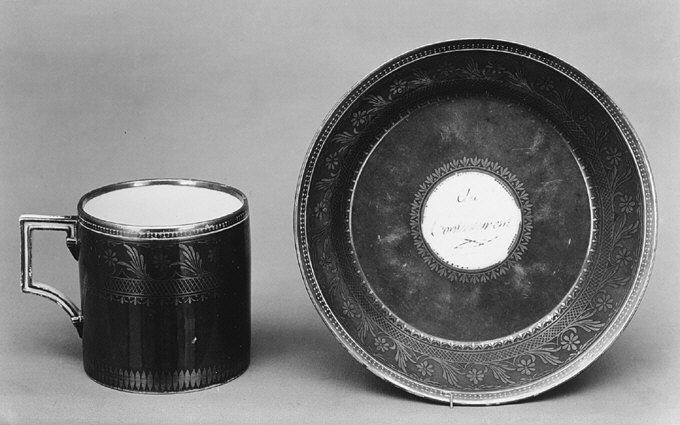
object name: cup and saucer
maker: meissen manufactory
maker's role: manufactory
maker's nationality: german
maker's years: 1710-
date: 1790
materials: hard paste porcelain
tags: flowers